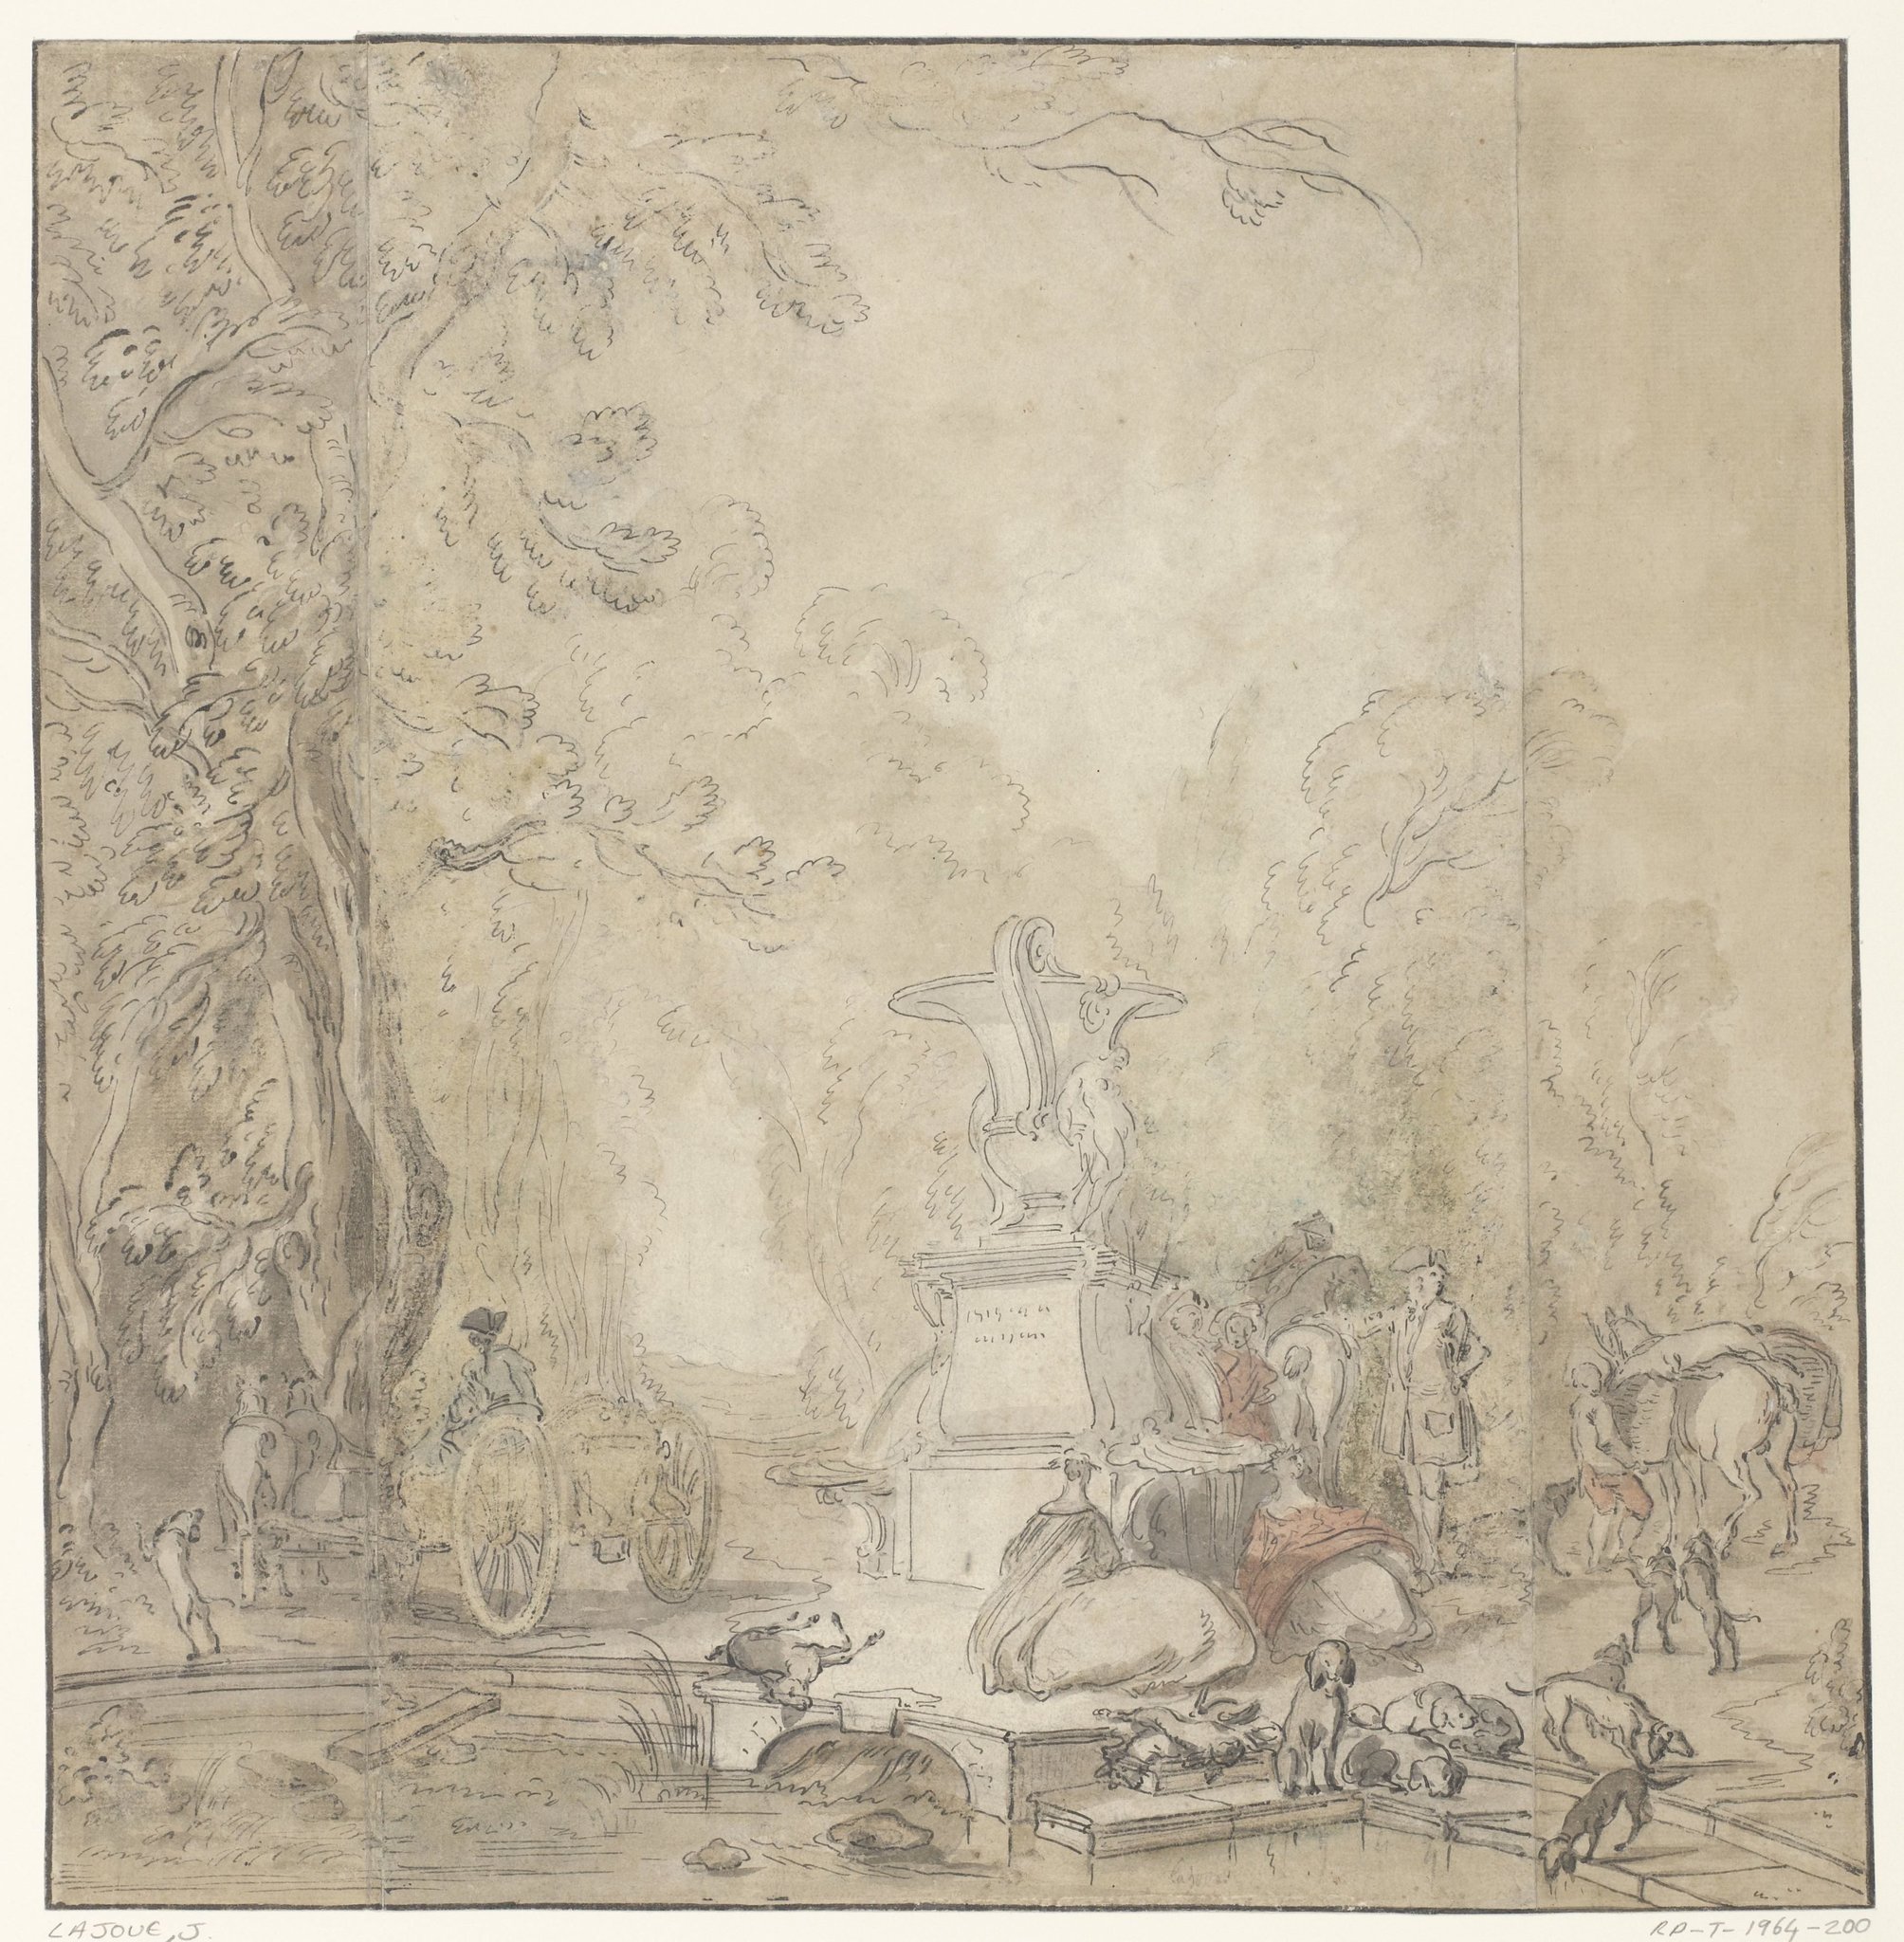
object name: drawing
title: Parkgezicht met een jachtgezelschap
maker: jacques lajoue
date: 1697-1761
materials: ink, paper, pencil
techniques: brush, pen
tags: assembling, 'départ pour la chasse', wood and park (as places of recreation)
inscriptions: collector's mark, verso, lower centre: Lugt 2228